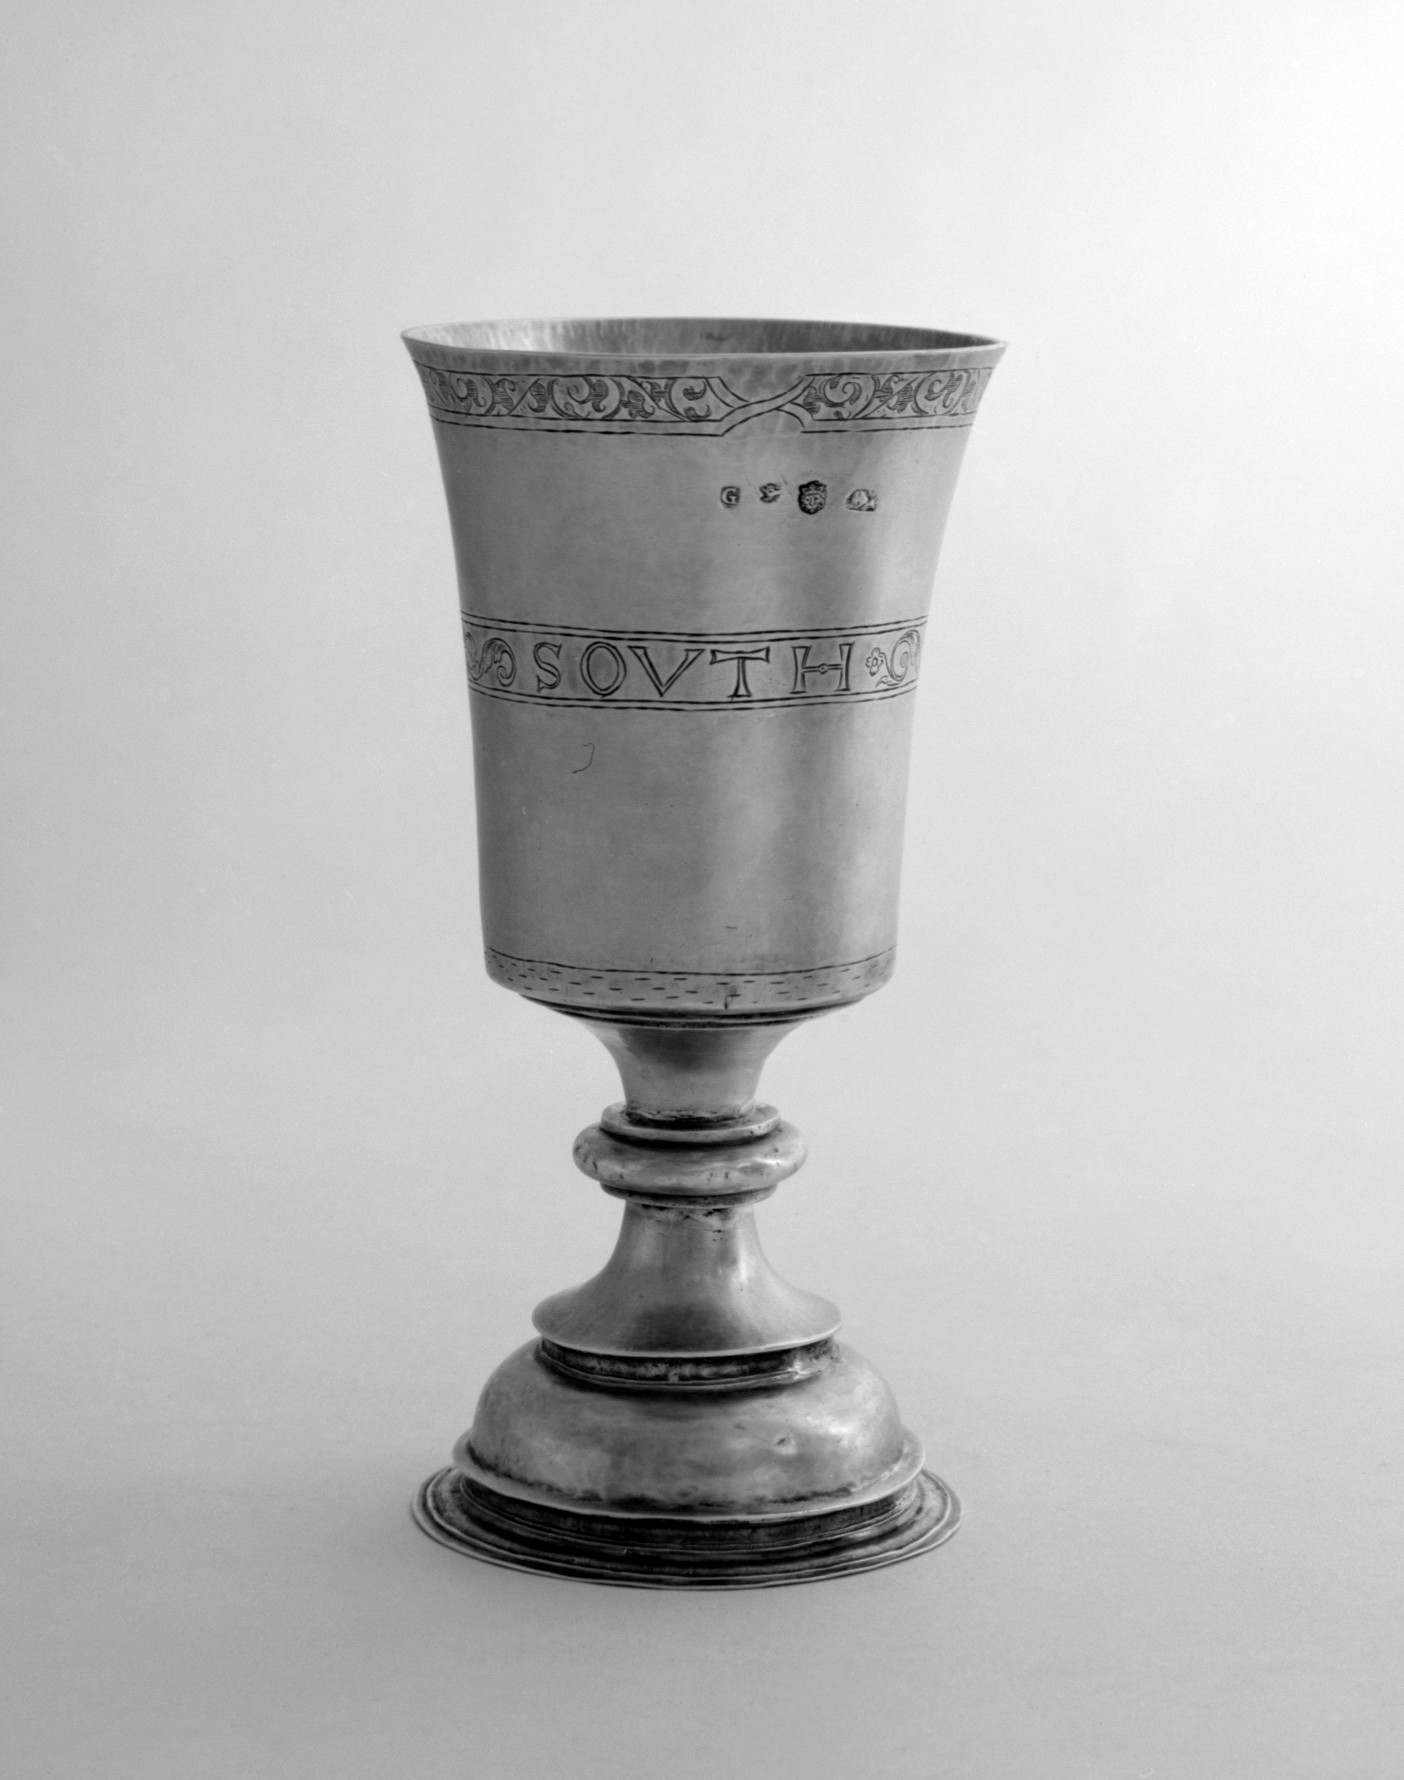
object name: communion cup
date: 1584-1585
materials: gilt, silver